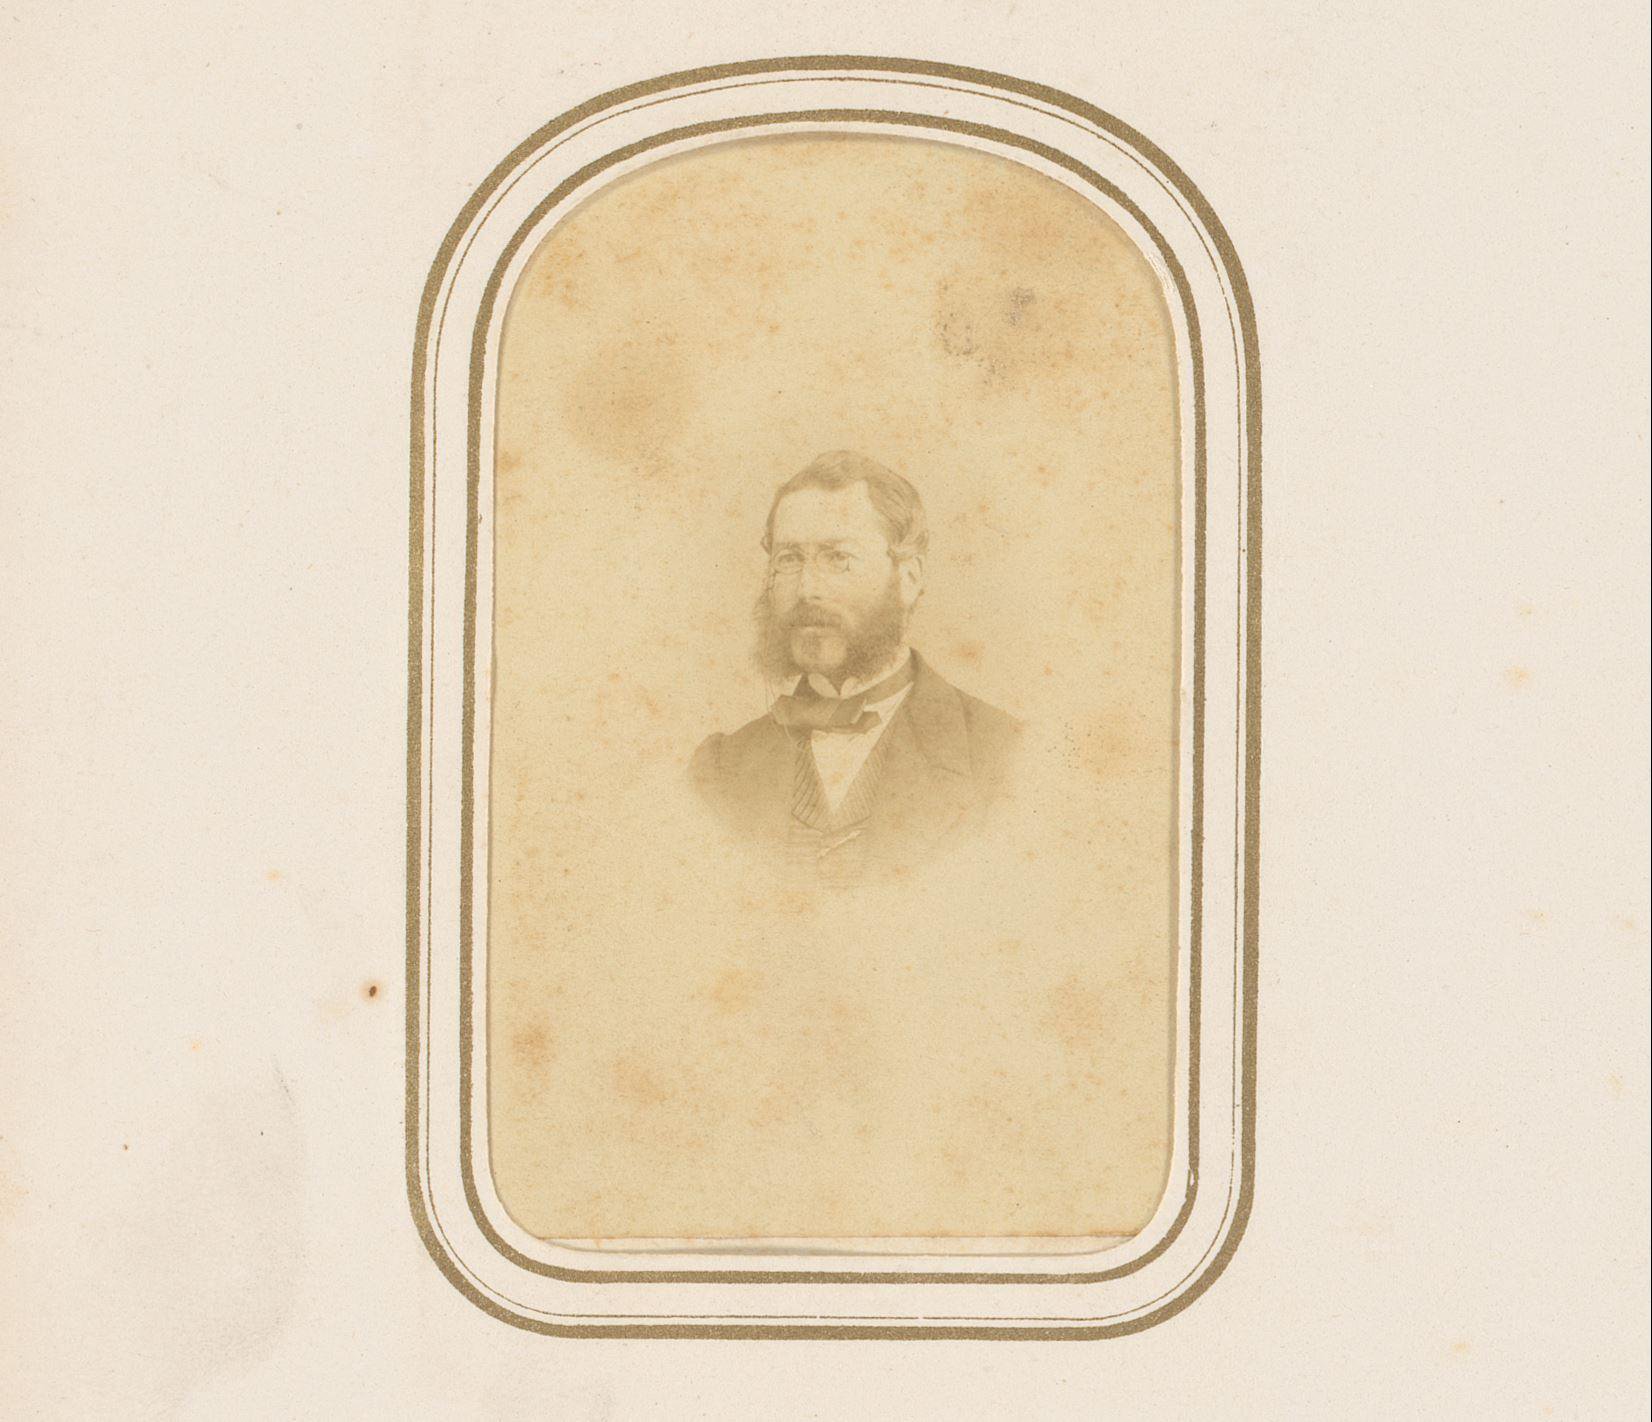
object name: album leaf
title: Portret van een man met bakkenbaarden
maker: alfred louviot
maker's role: fotograaf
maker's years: 1835-1891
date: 1863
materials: cardboard, photographic support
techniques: albumen print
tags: sideburns, adult man, historical persons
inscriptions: annotation: ‘[...] 1863’, inscription: ‘A. Louviot/ Photographe/ 14. Rue du Nord/ Melun’